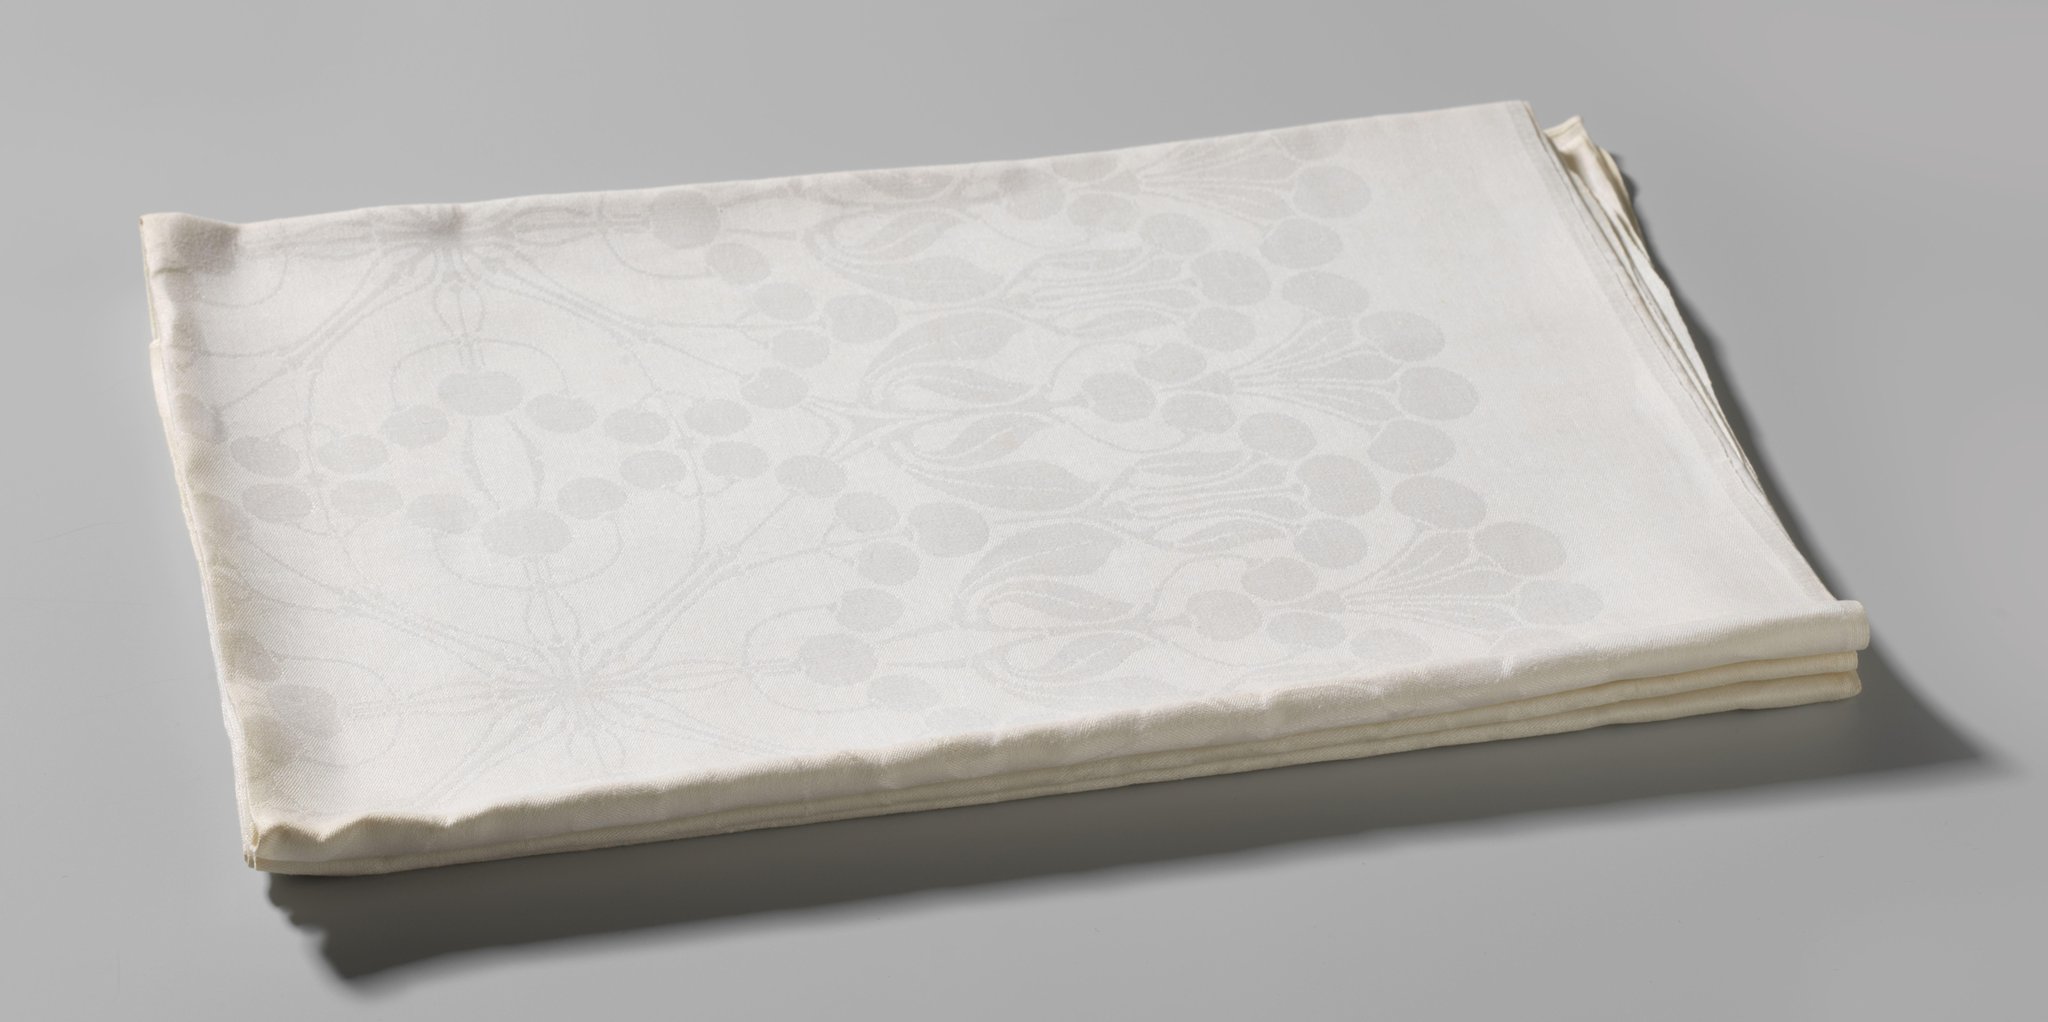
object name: tablecloth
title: Tafellaken van wit linnendamast, dessin 600, motief Kers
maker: chris lebeau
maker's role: draughtsman, print maker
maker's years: 1878-1945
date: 1910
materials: linen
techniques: damask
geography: eindhoven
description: Tafellaken van wit linnendamast, dessin 600, motief Kers.